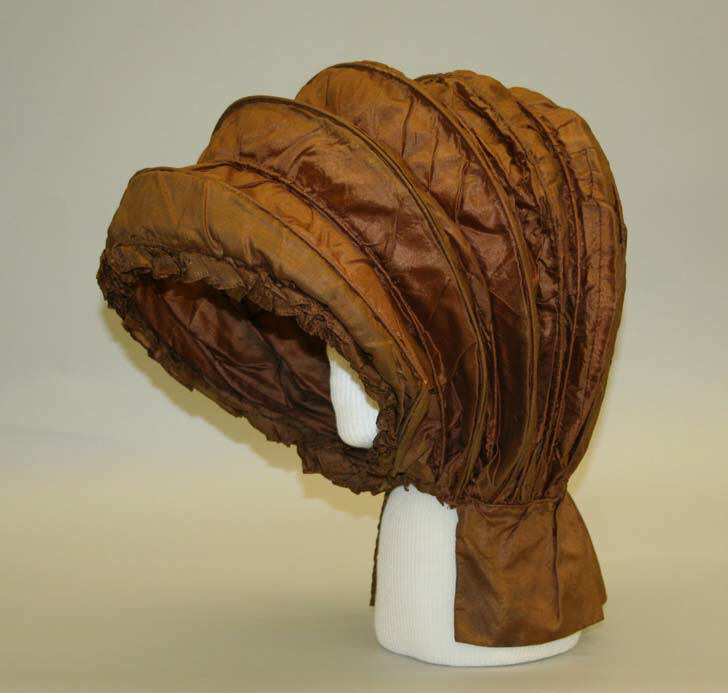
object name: calash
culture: american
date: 1810-1820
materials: silk